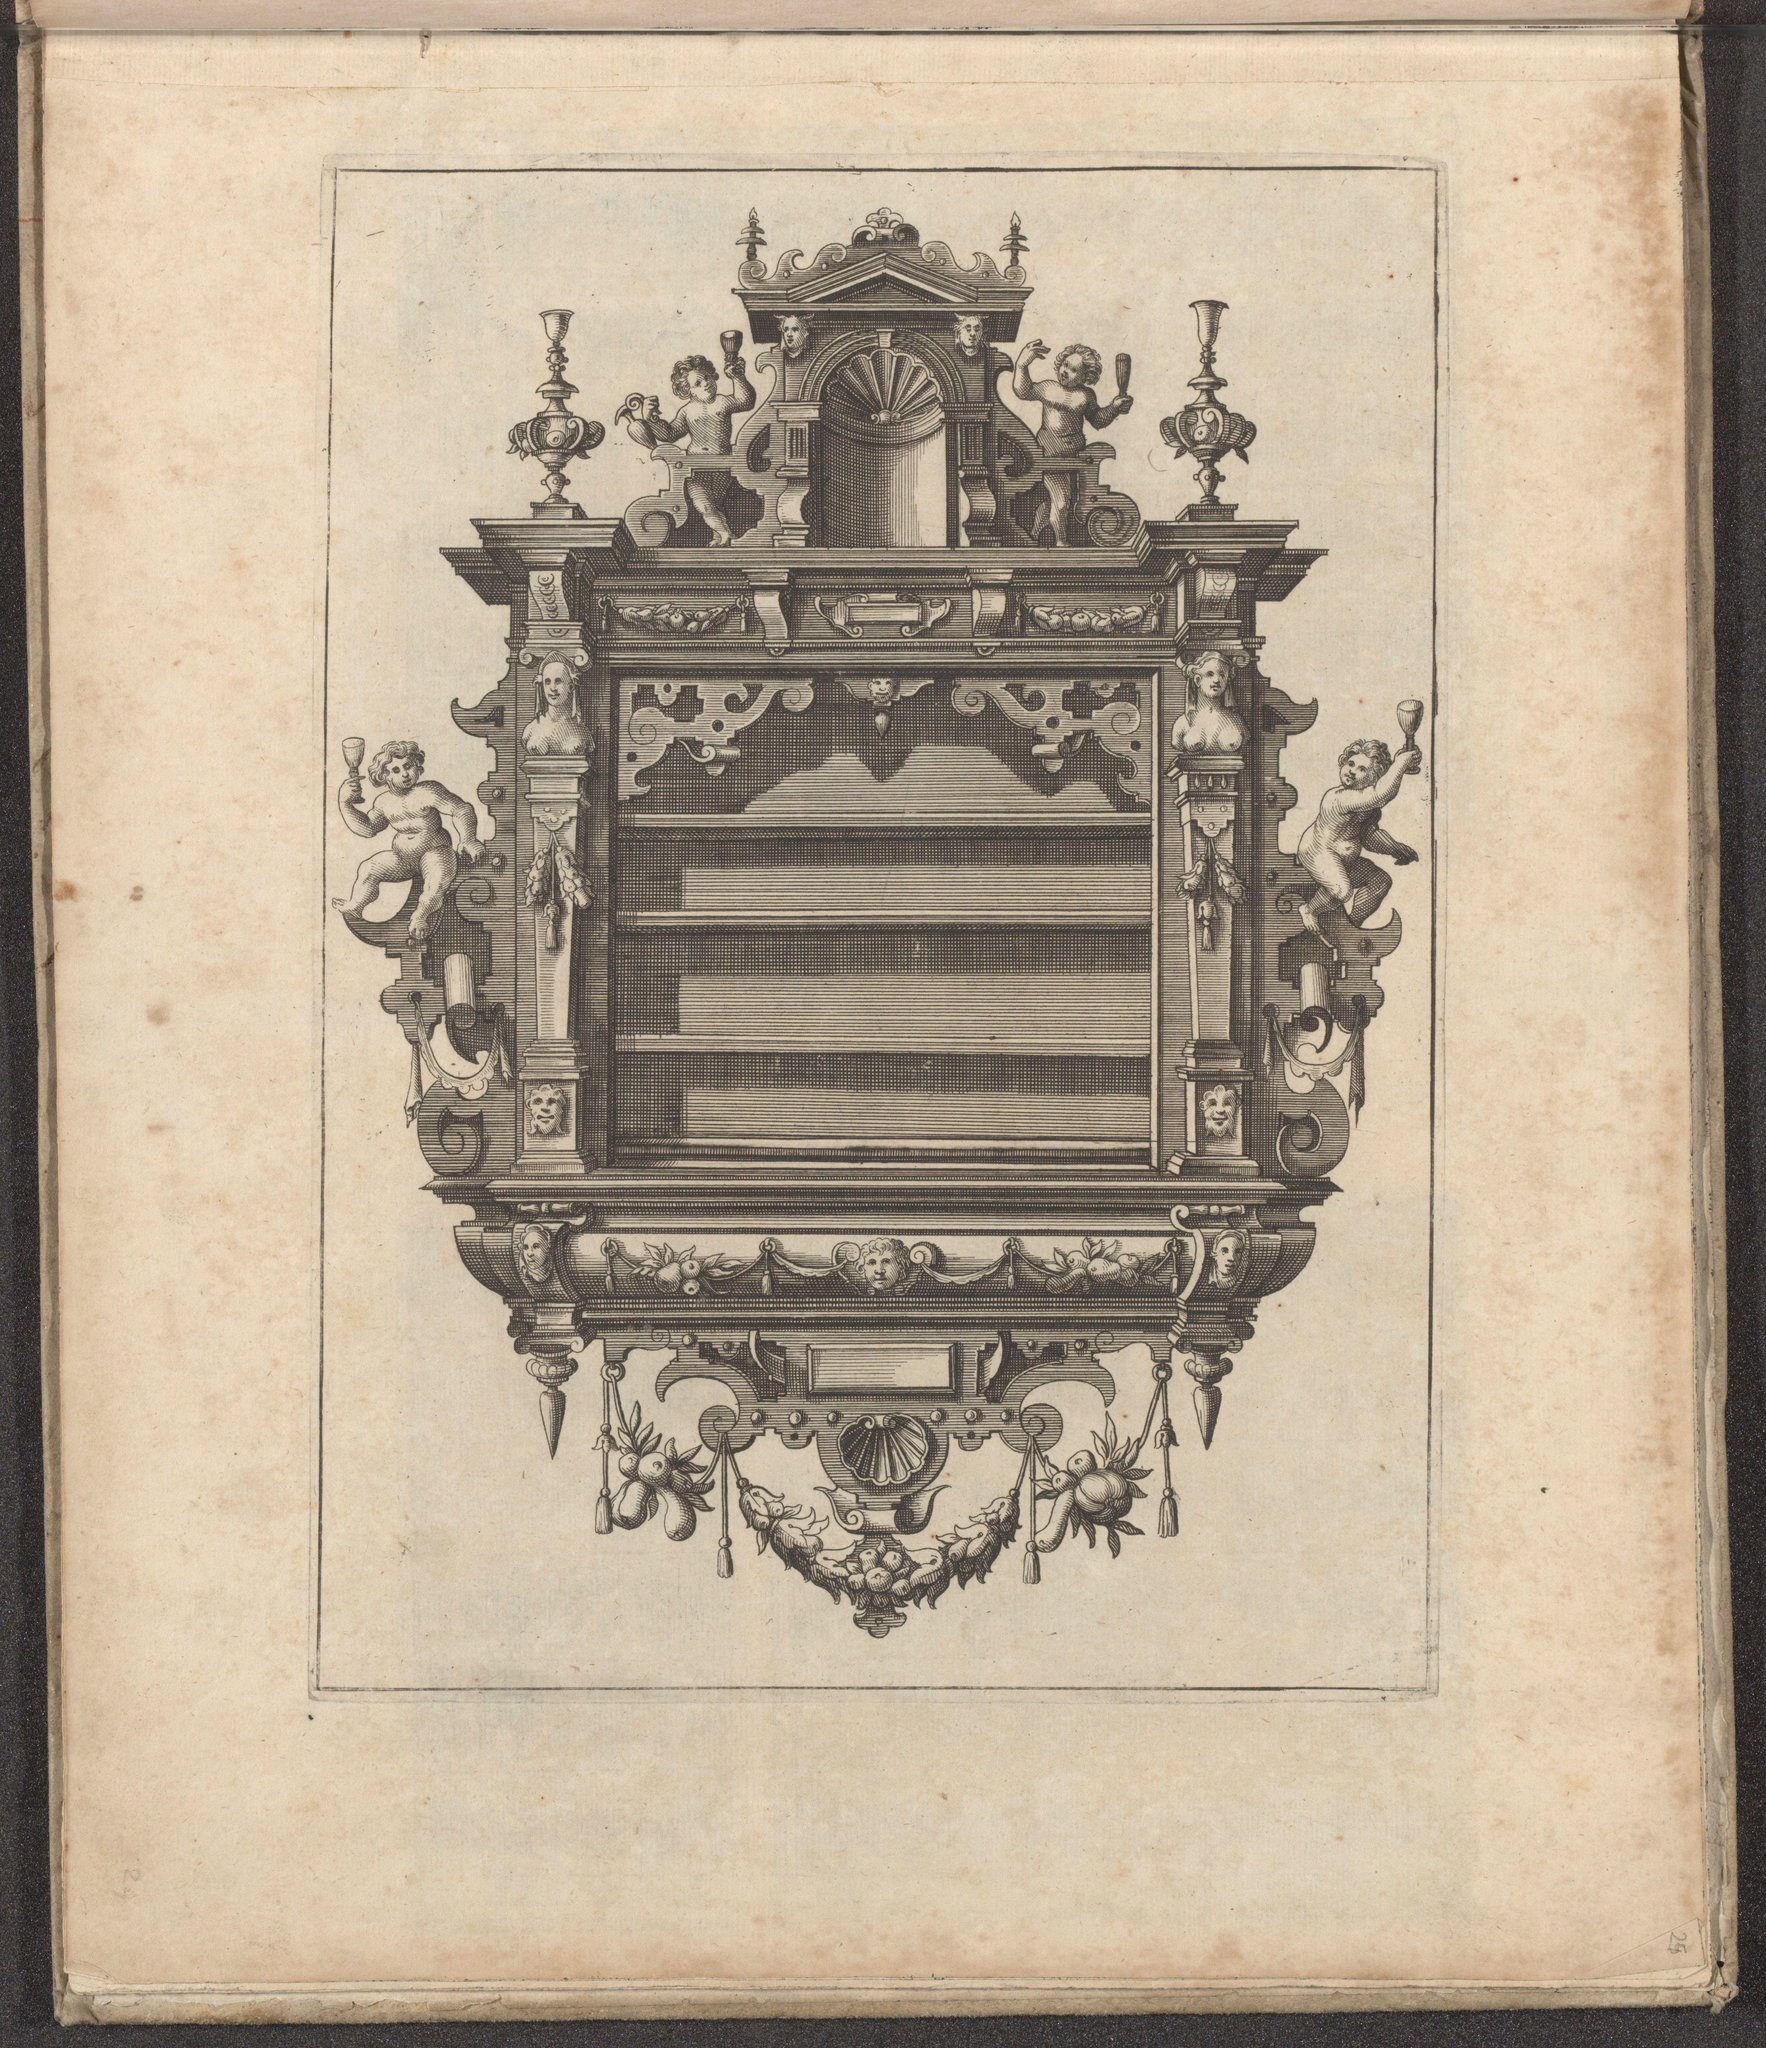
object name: album leaf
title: Verscheidene Schreinwercke / Plusieurs Menuiseries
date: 1658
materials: paper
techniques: engraving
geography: cologne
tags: furniture for storage, furniture and household effects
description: Muurkabinet met vier putti die een glas heffen. De prent maakt deel uit van een album.